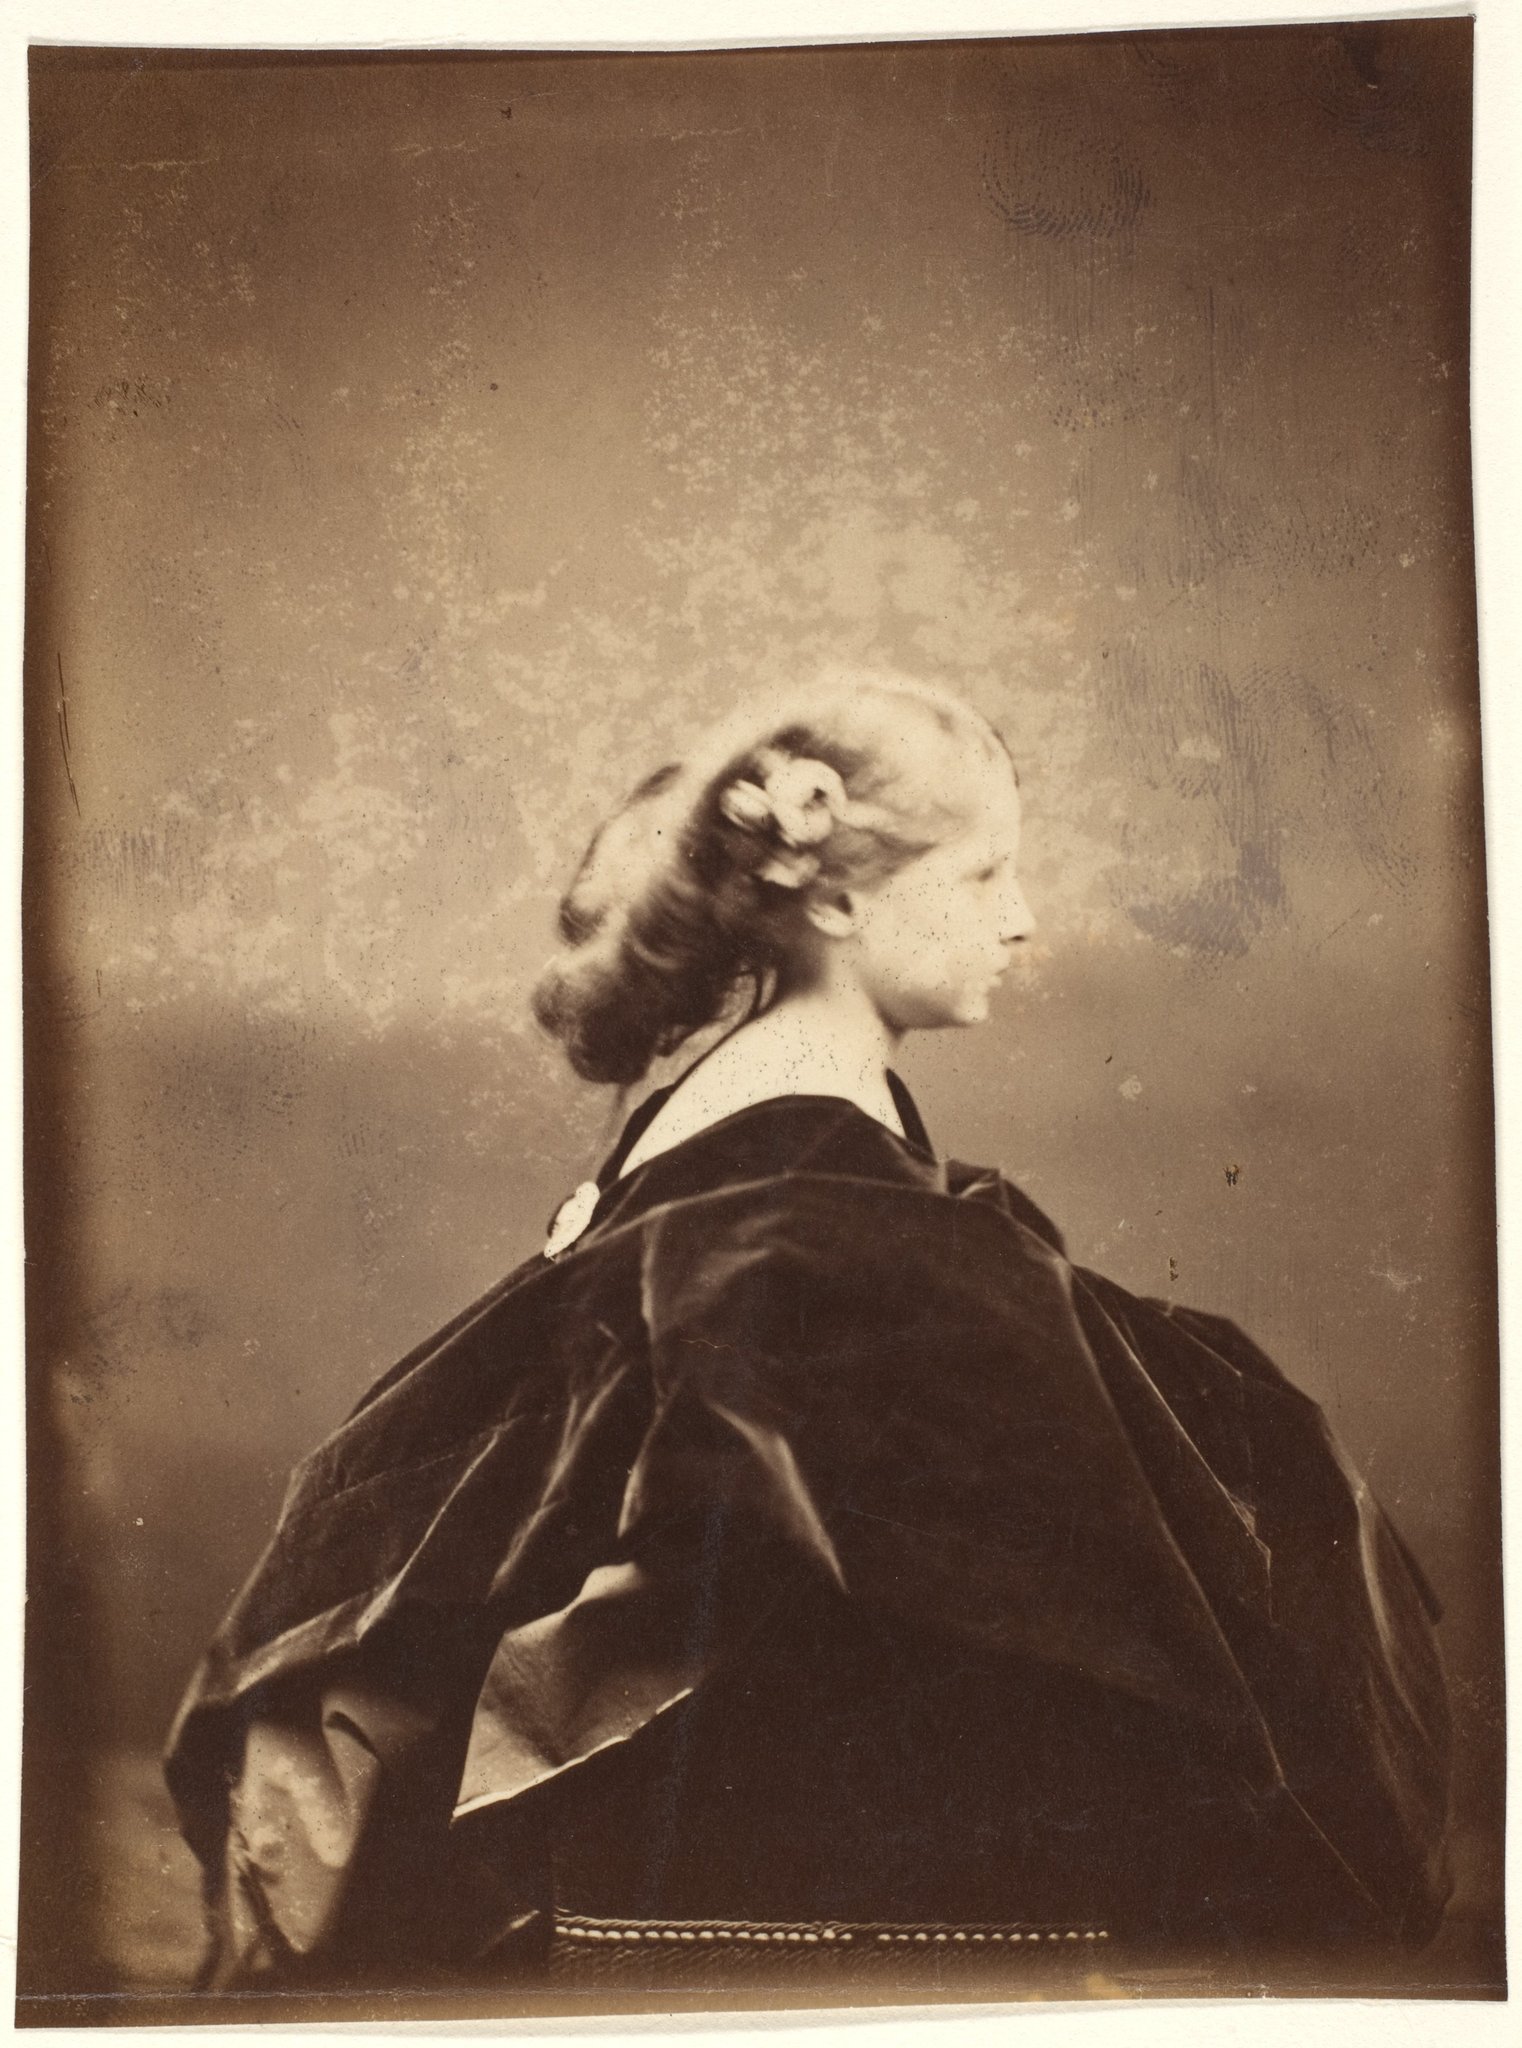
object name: photograph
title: La fillette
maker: pierre-louis pierson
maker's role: artist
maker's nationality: french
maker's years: 1822-1913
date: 1860-1869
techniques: albumen silver print, glass negative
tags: girls,portraits,profiles